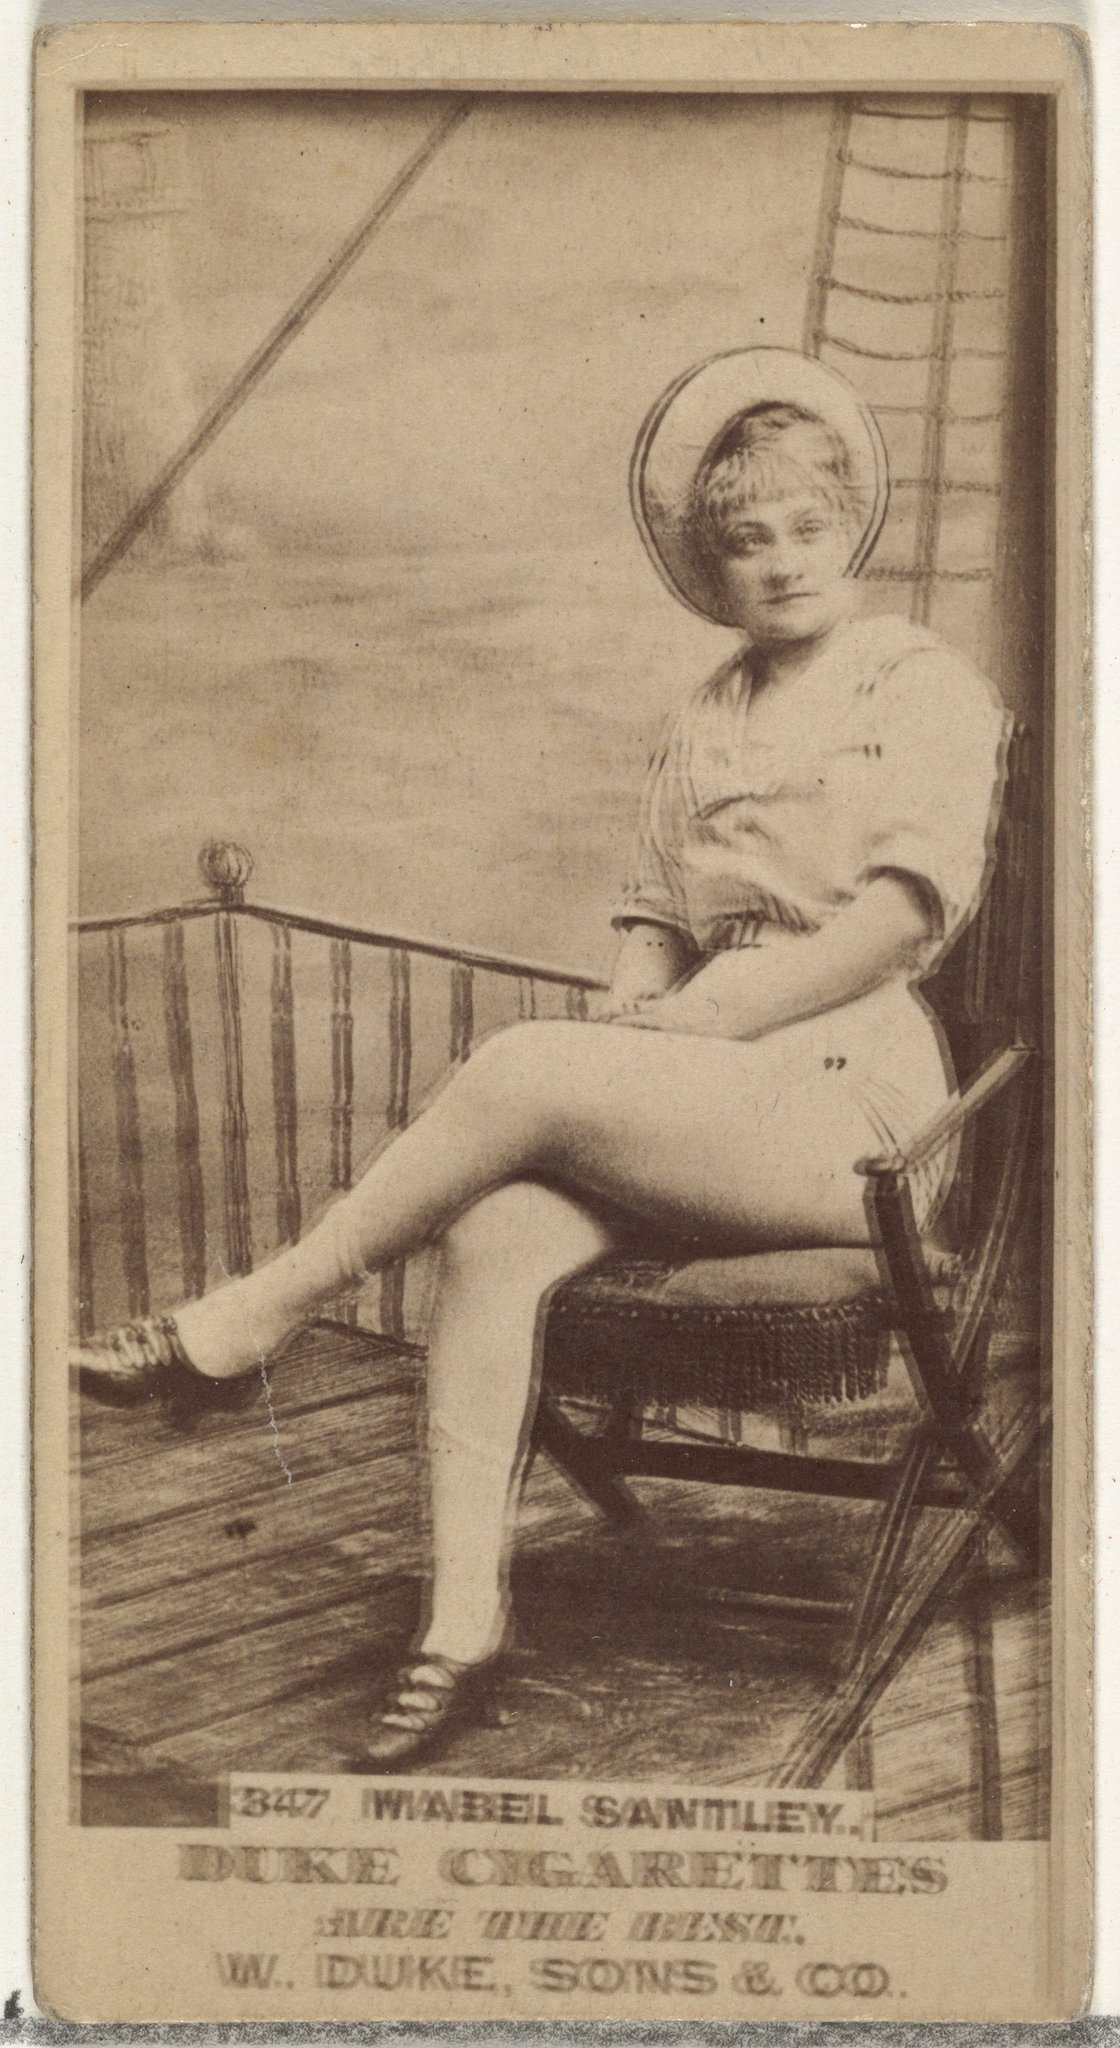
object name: photograph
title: Card Number 347, Mabel Santley, from the Actors and Actresses series (N145-7) issued by Duke Sons & Co. to promote Duke Cigarettes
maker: w. duke, sons & co.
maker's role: publisher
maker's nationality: american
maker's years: 1870-1920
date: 1880-1889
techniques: albumen silver print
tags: portraits,women,actresses